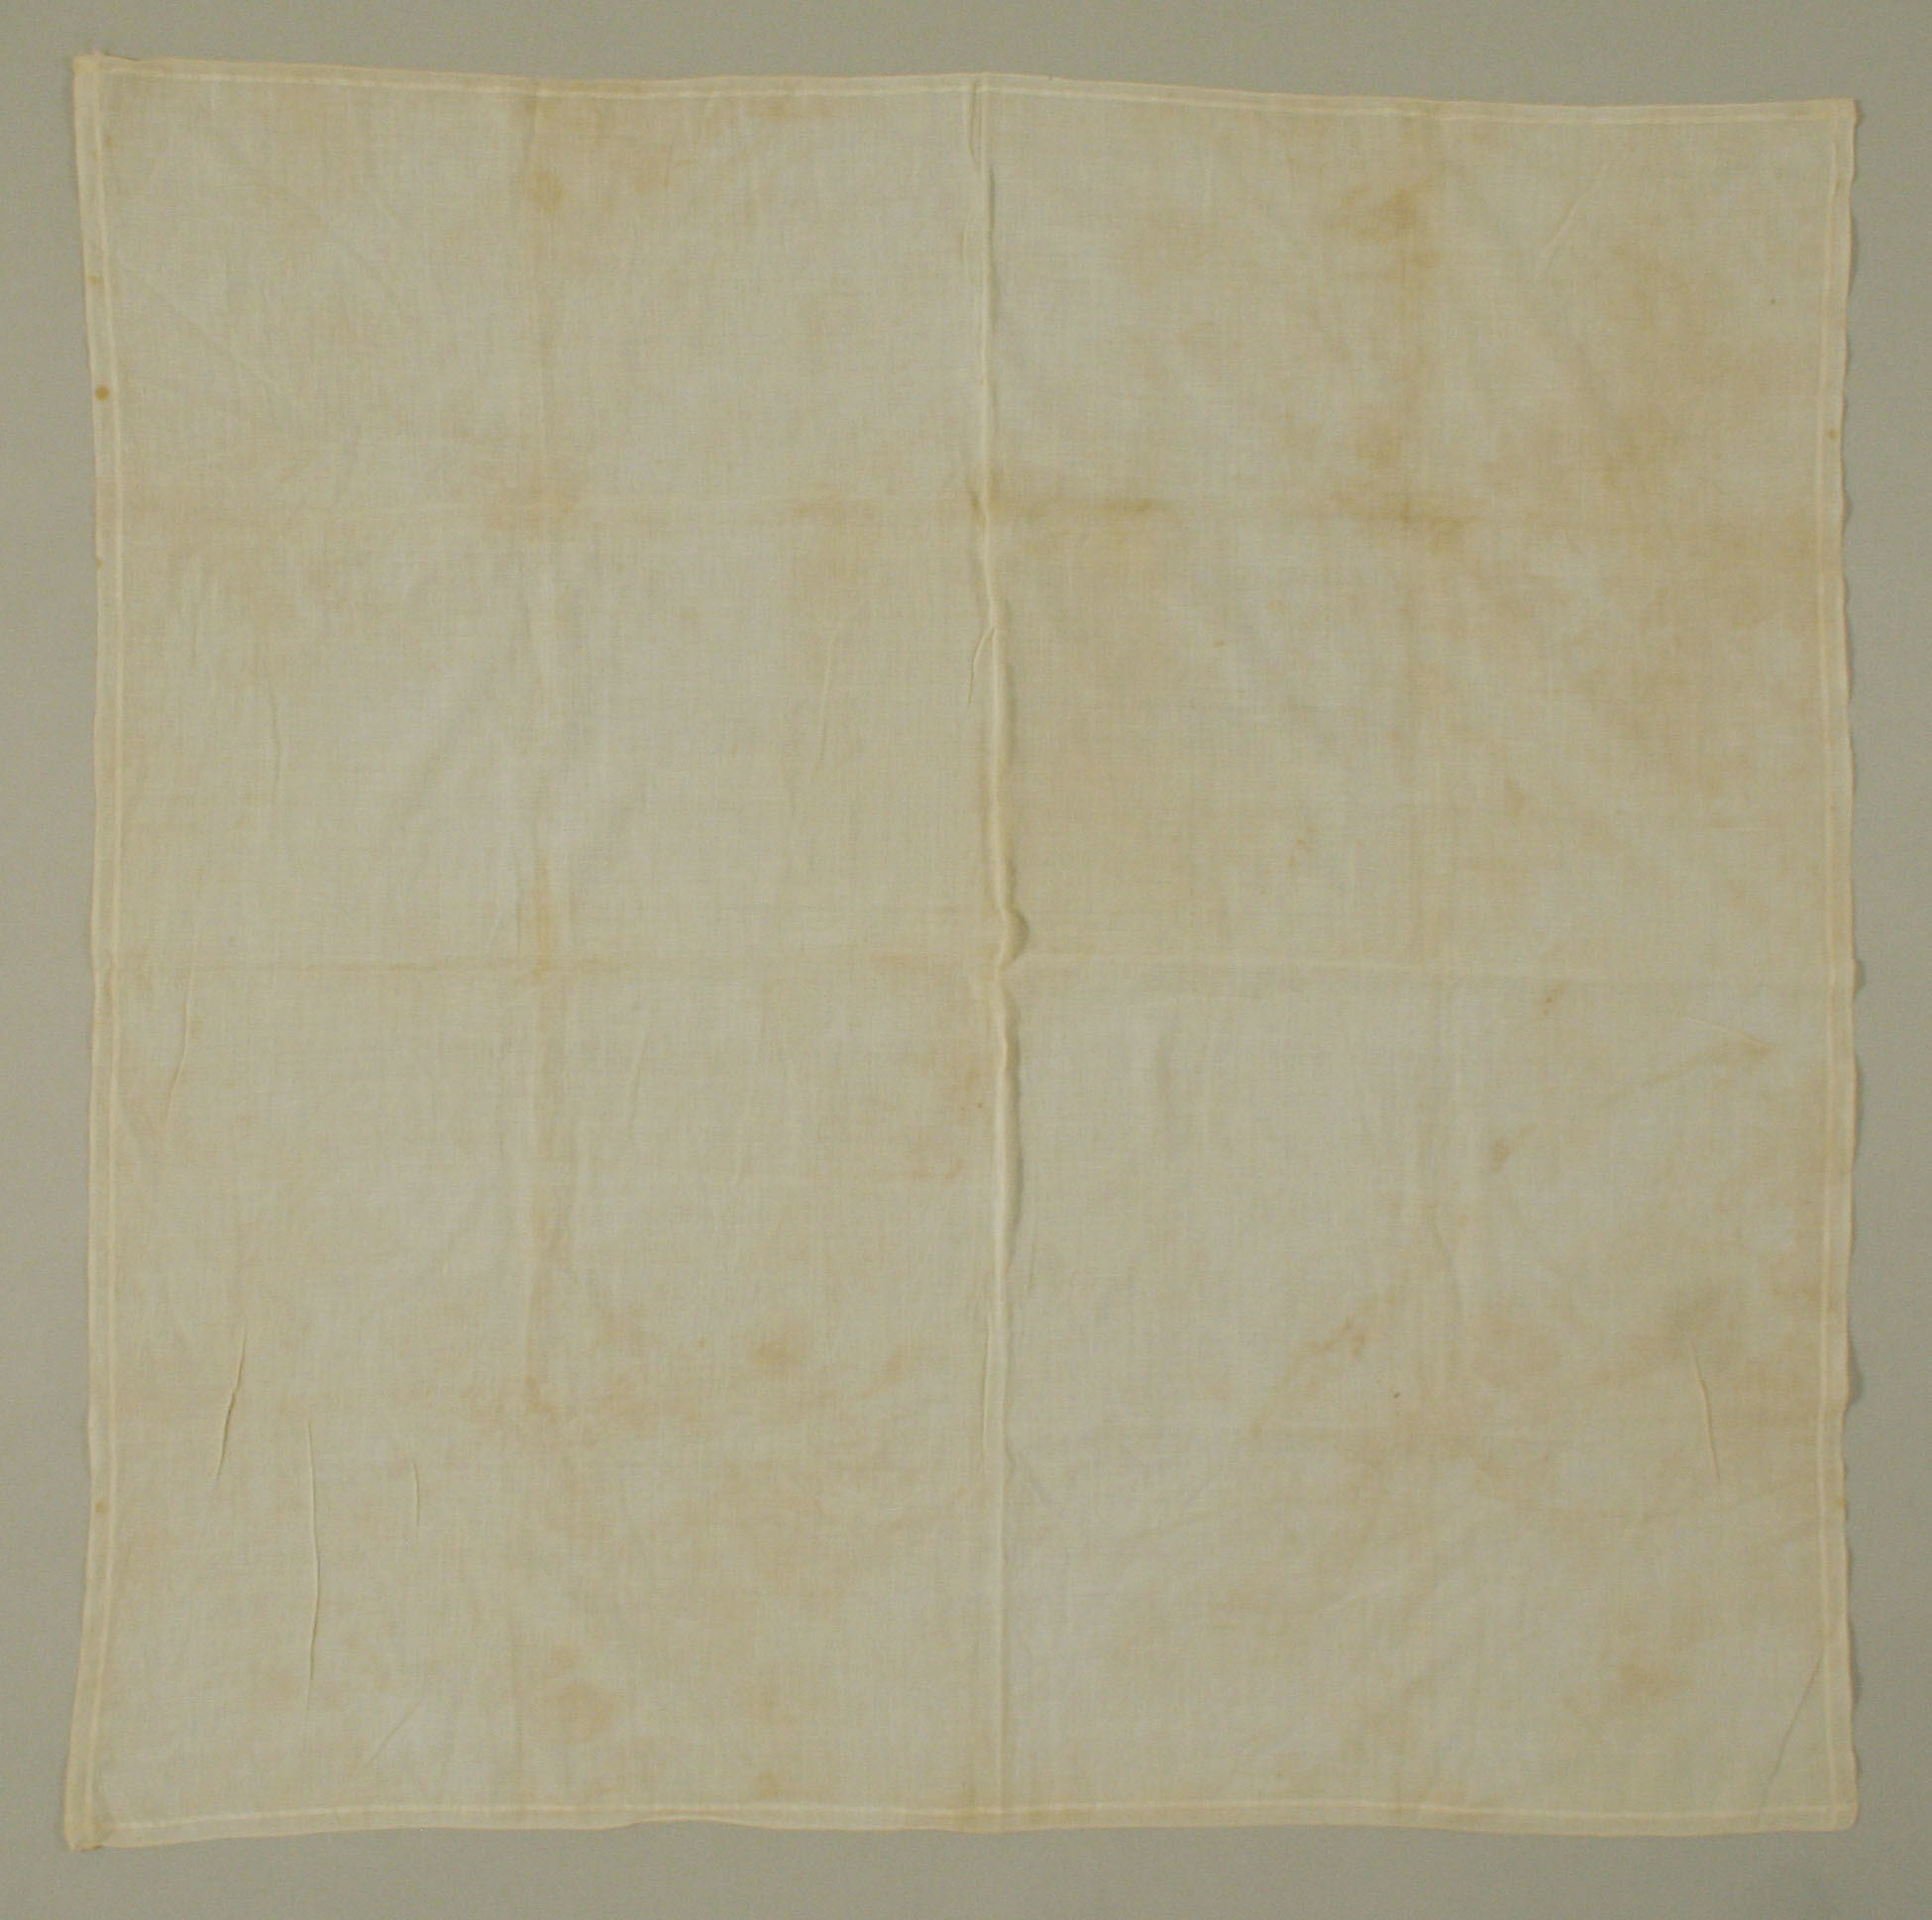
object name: fichu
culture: american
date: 1701-1800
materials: cotton